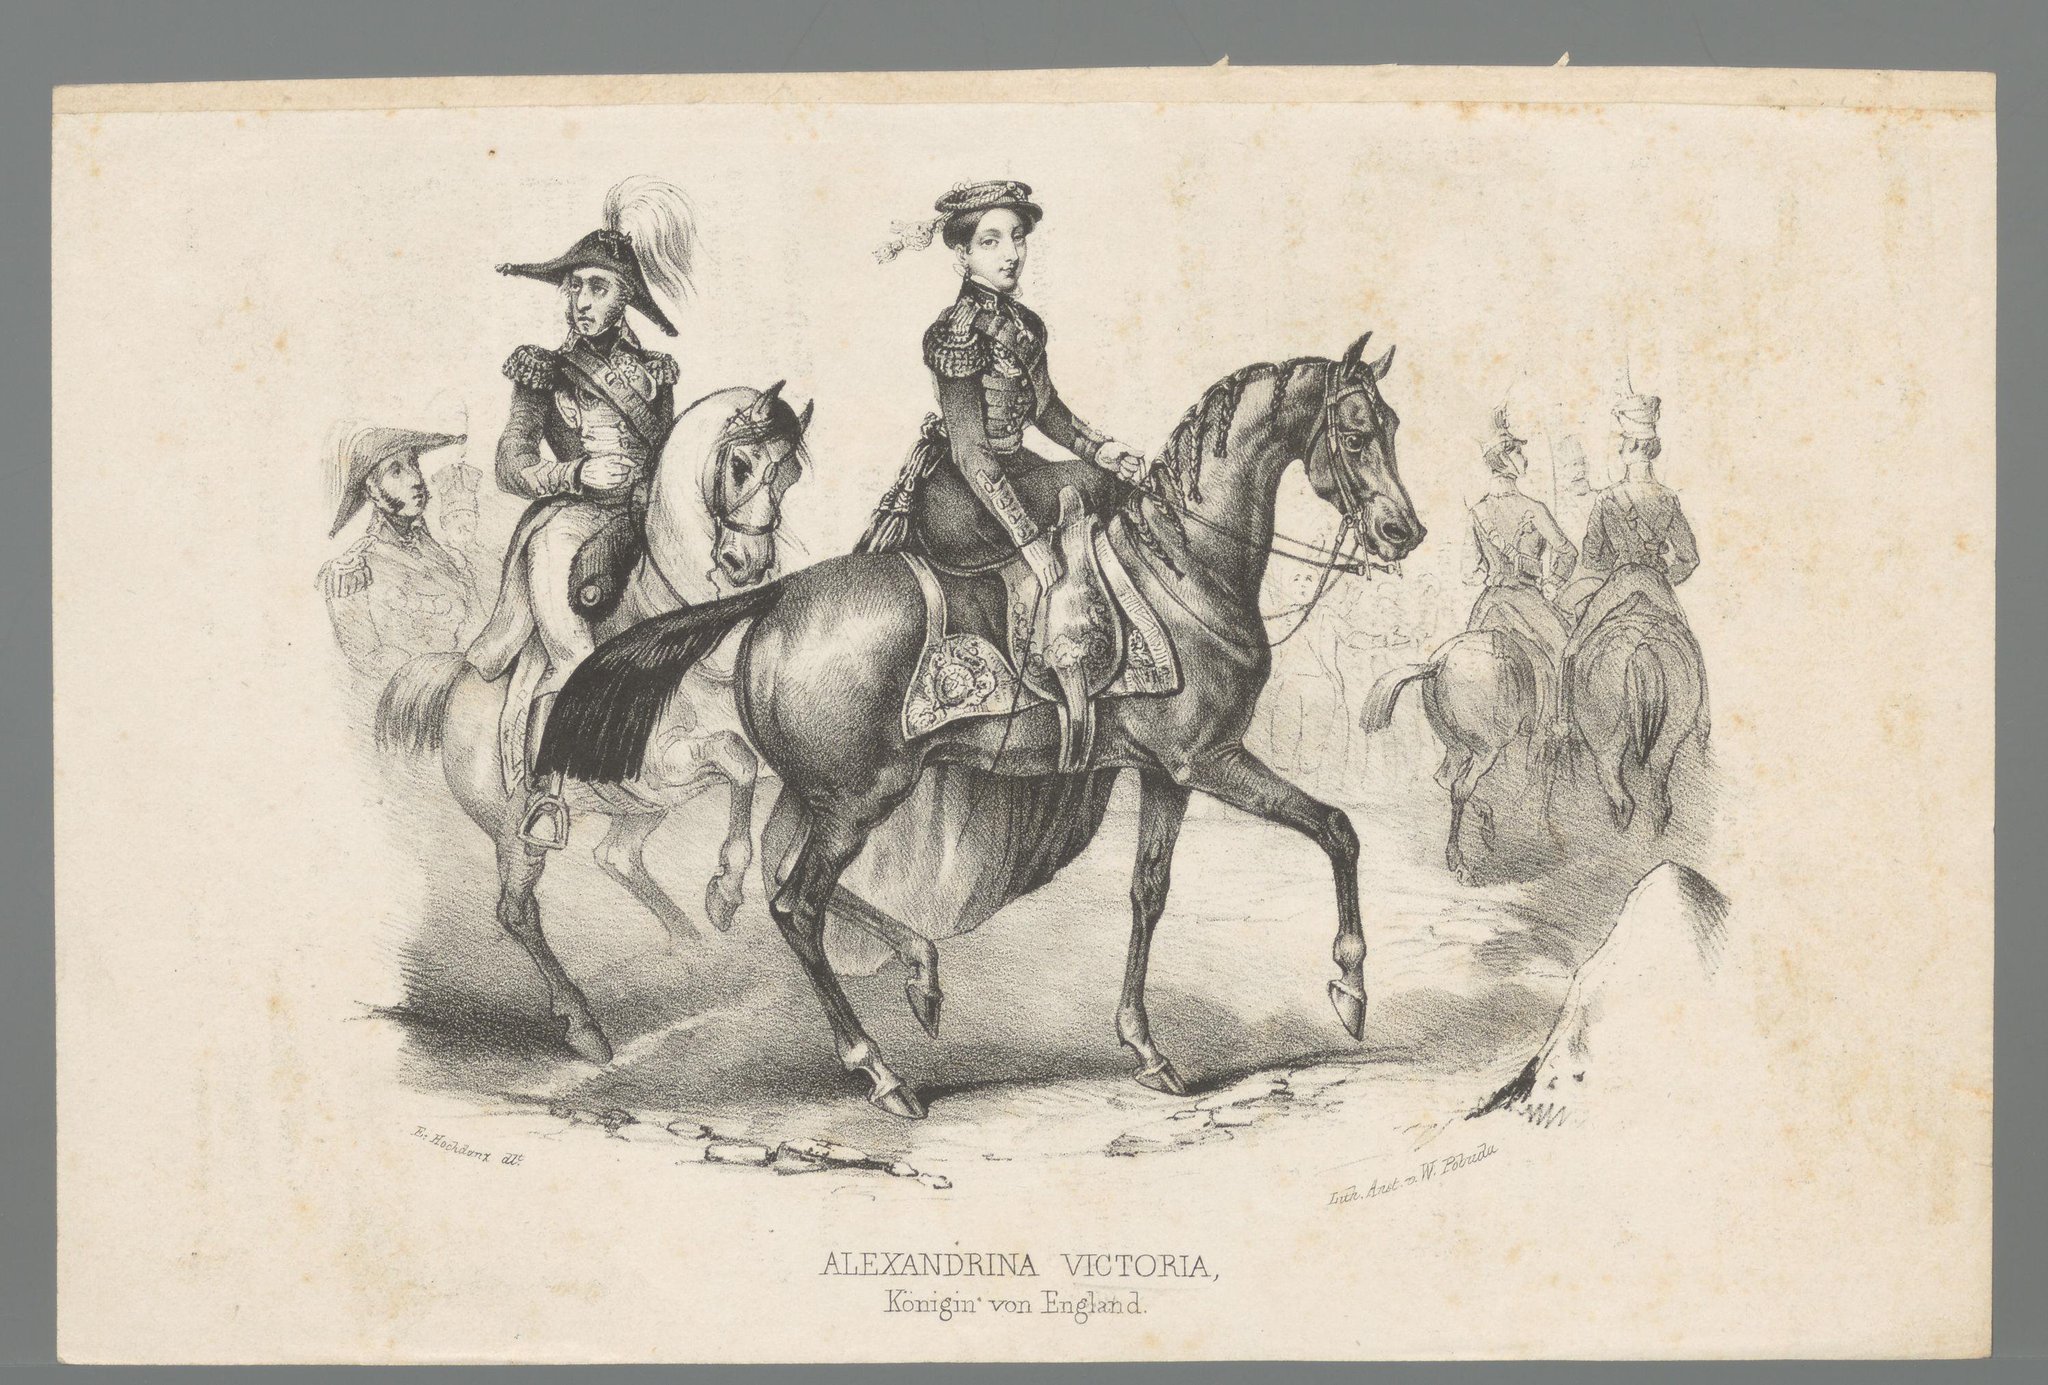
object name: print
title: Koningin Victoria te paard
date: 1826-1885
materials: paper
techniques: lithograph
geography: stuttgart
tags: victoria (koningin van het verenigd koninkrijk en keizerin van india), riding a horse, ass, or mule; rider, horseman, adult woman, historical persons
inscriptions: collector's mark: Lugt 2228